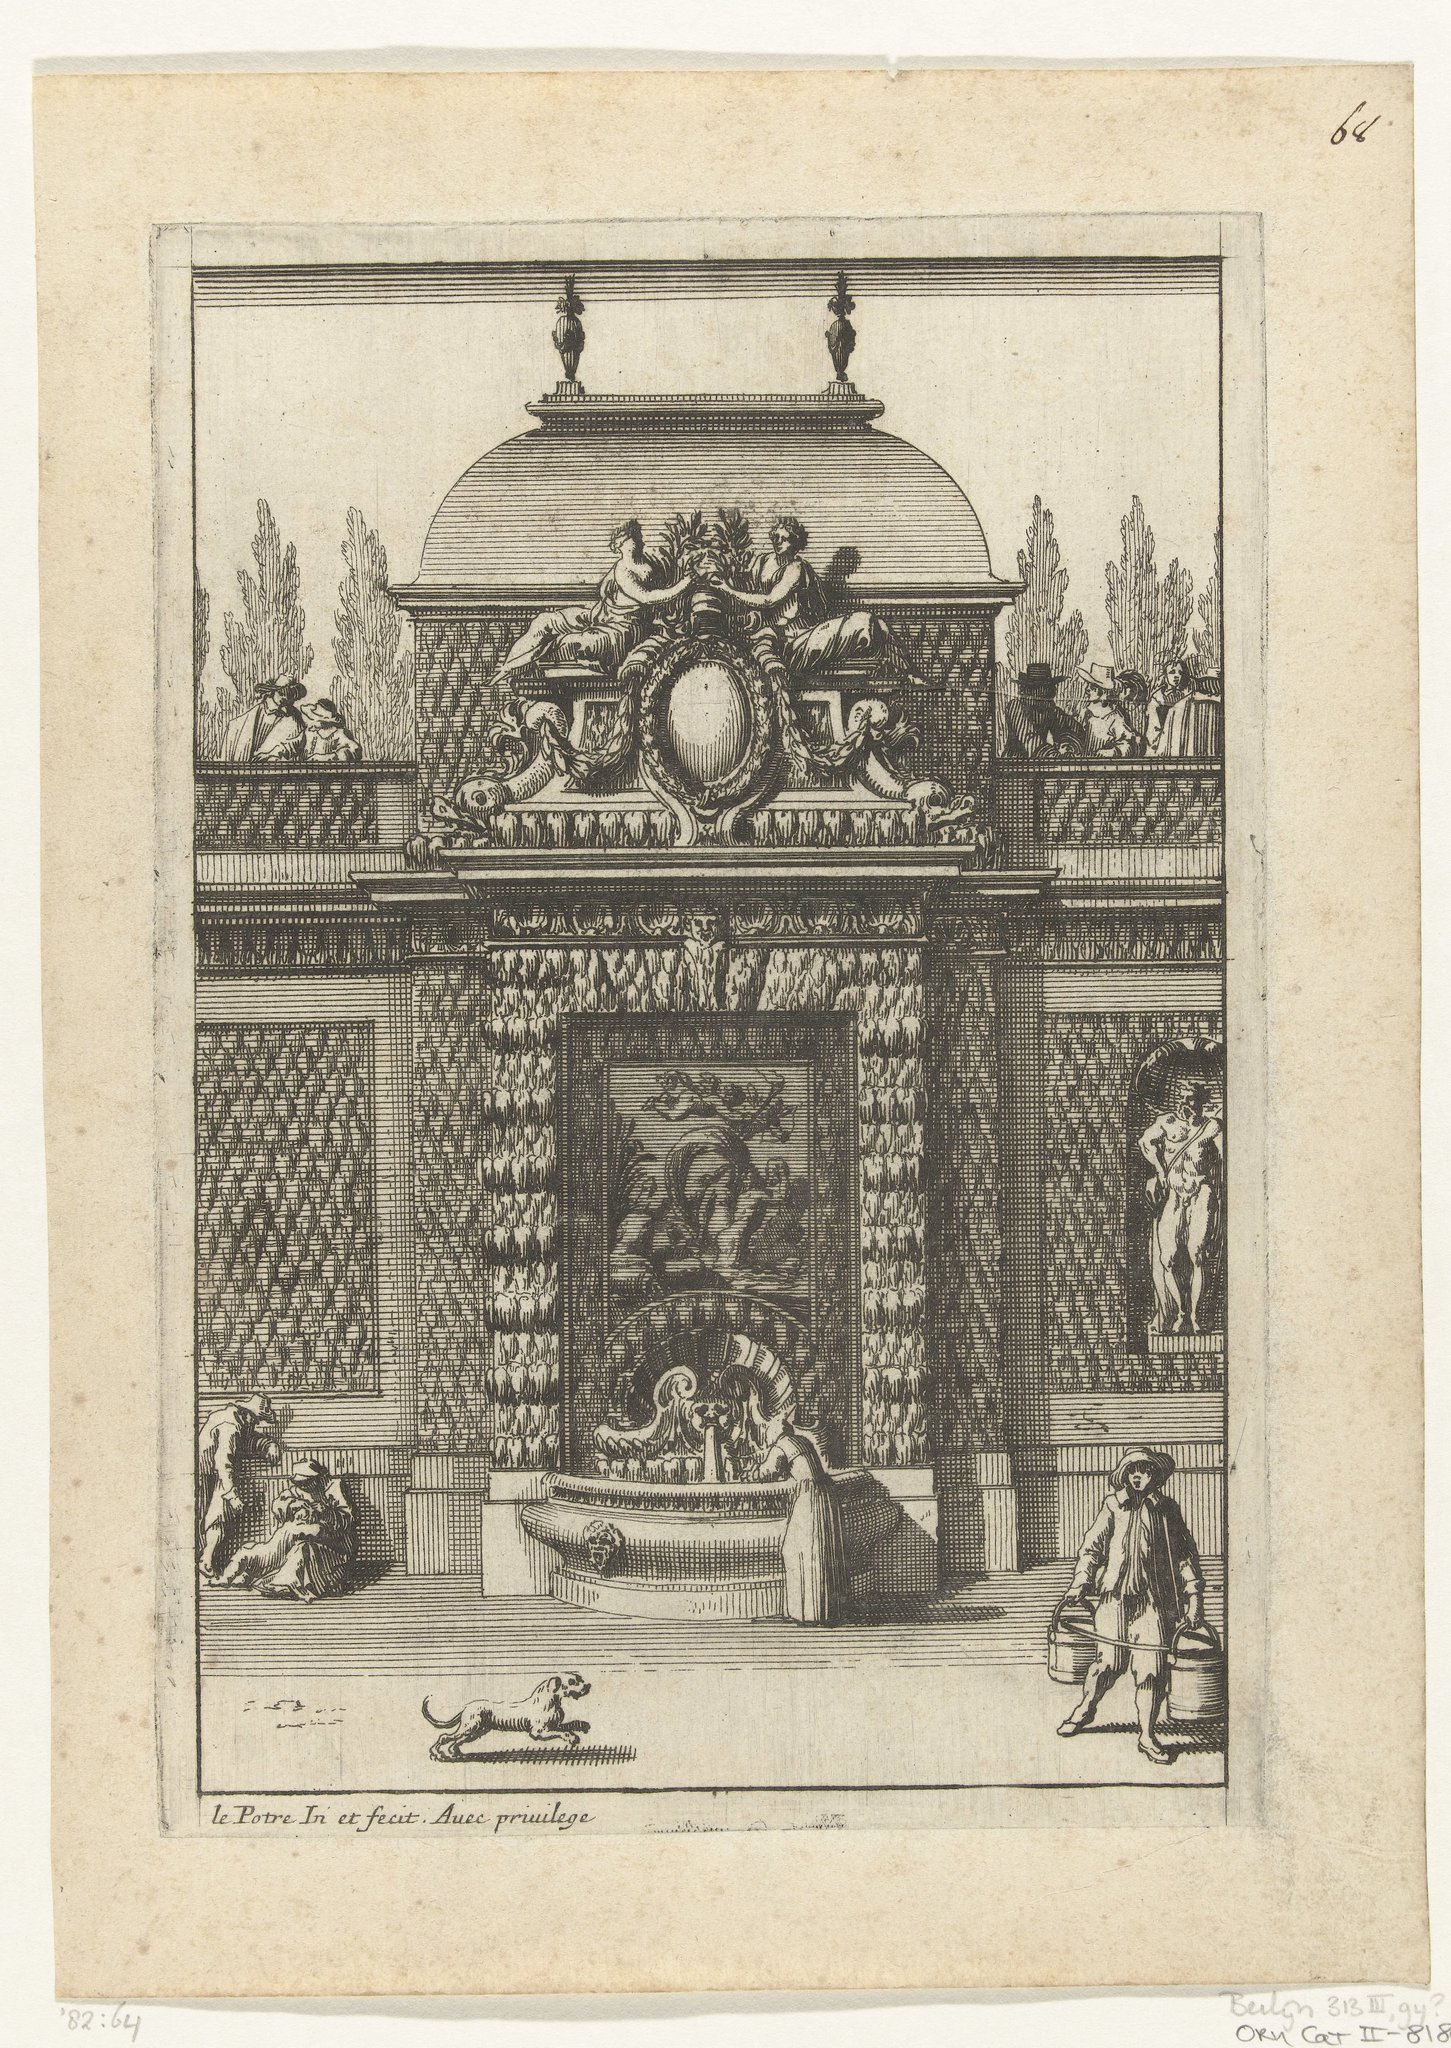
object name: ornament print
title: Muurfontein met bassin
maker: jean lepautre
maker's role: draughtsman, print maker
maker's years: 1618-1682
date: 1628-1682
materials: paper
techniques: etching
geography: paris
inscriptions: number: ‘68’